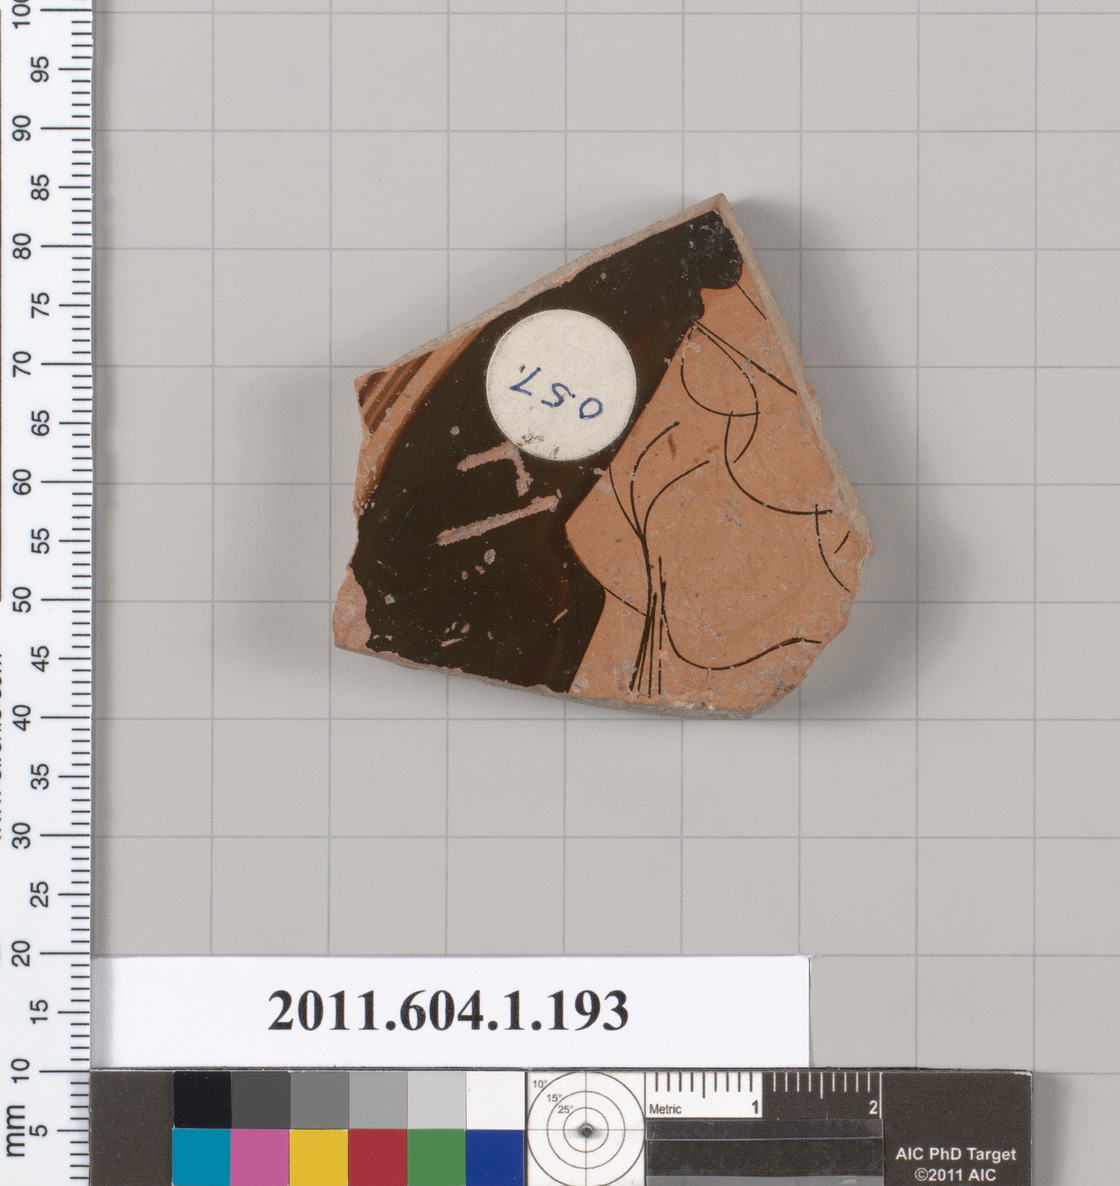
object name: kylix fragment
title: Terracotta fragment of a kylix (drinking cup)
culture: greek, attic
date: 475-451 BCE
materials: terracotta